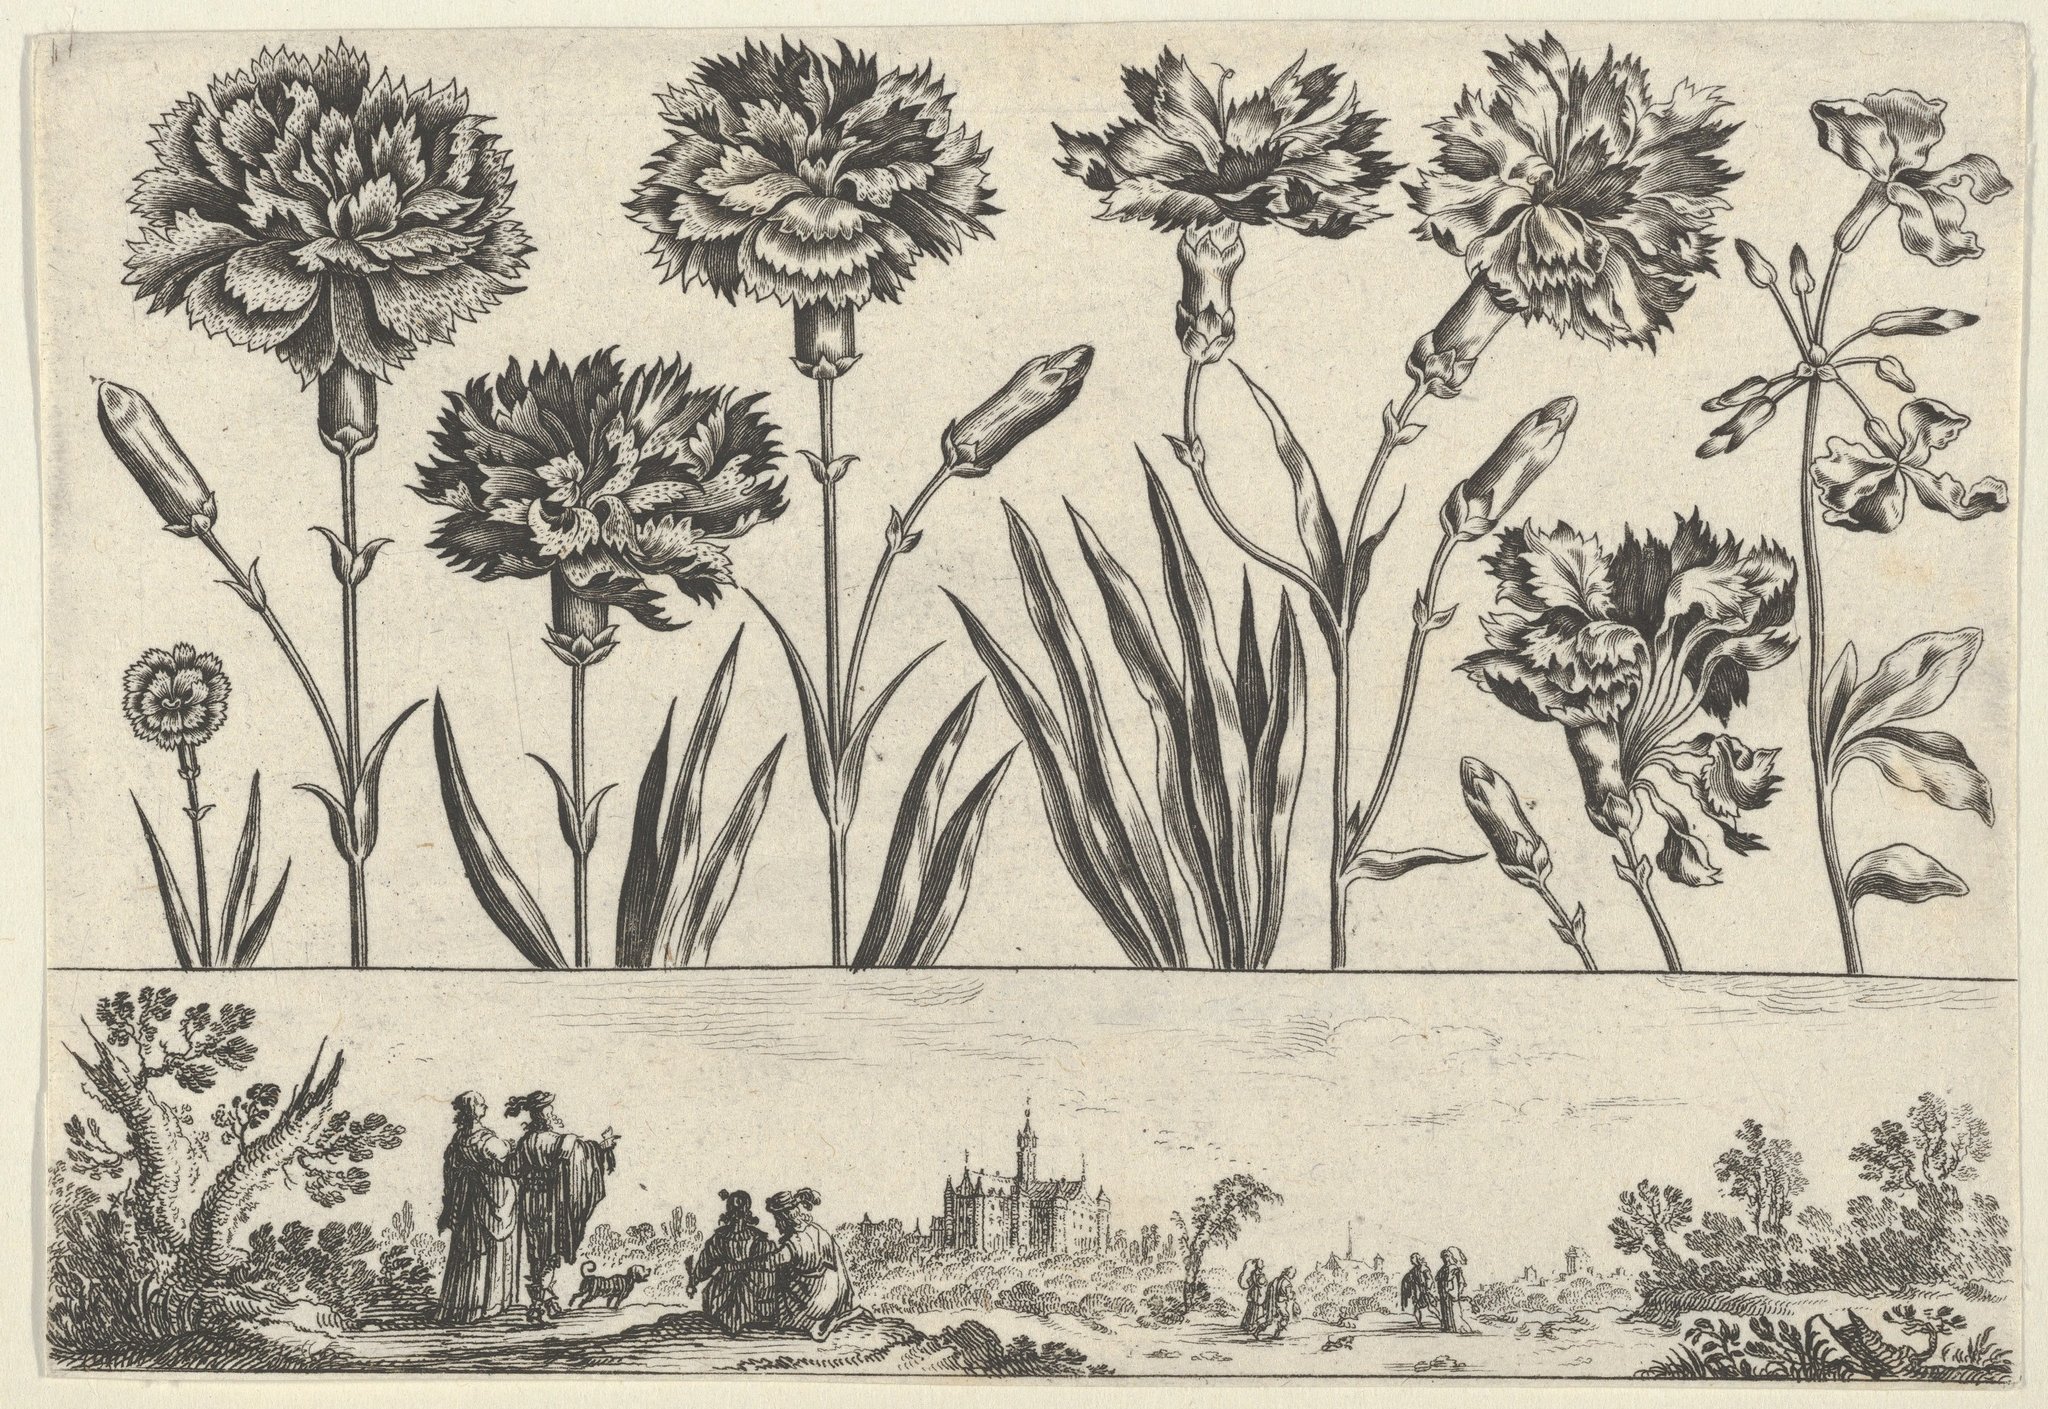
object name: print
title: Horizontal Panel with a Row of Flowers Above a Frieze with Figures in a Landscape, from "Livre Nouveau de Fleurs Tres-Util"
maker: nicolas cochin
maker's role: artist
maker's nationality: french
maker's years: 1610-1686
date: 1645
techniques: engraving, etching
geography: france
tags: human figures,flowers,landscapes